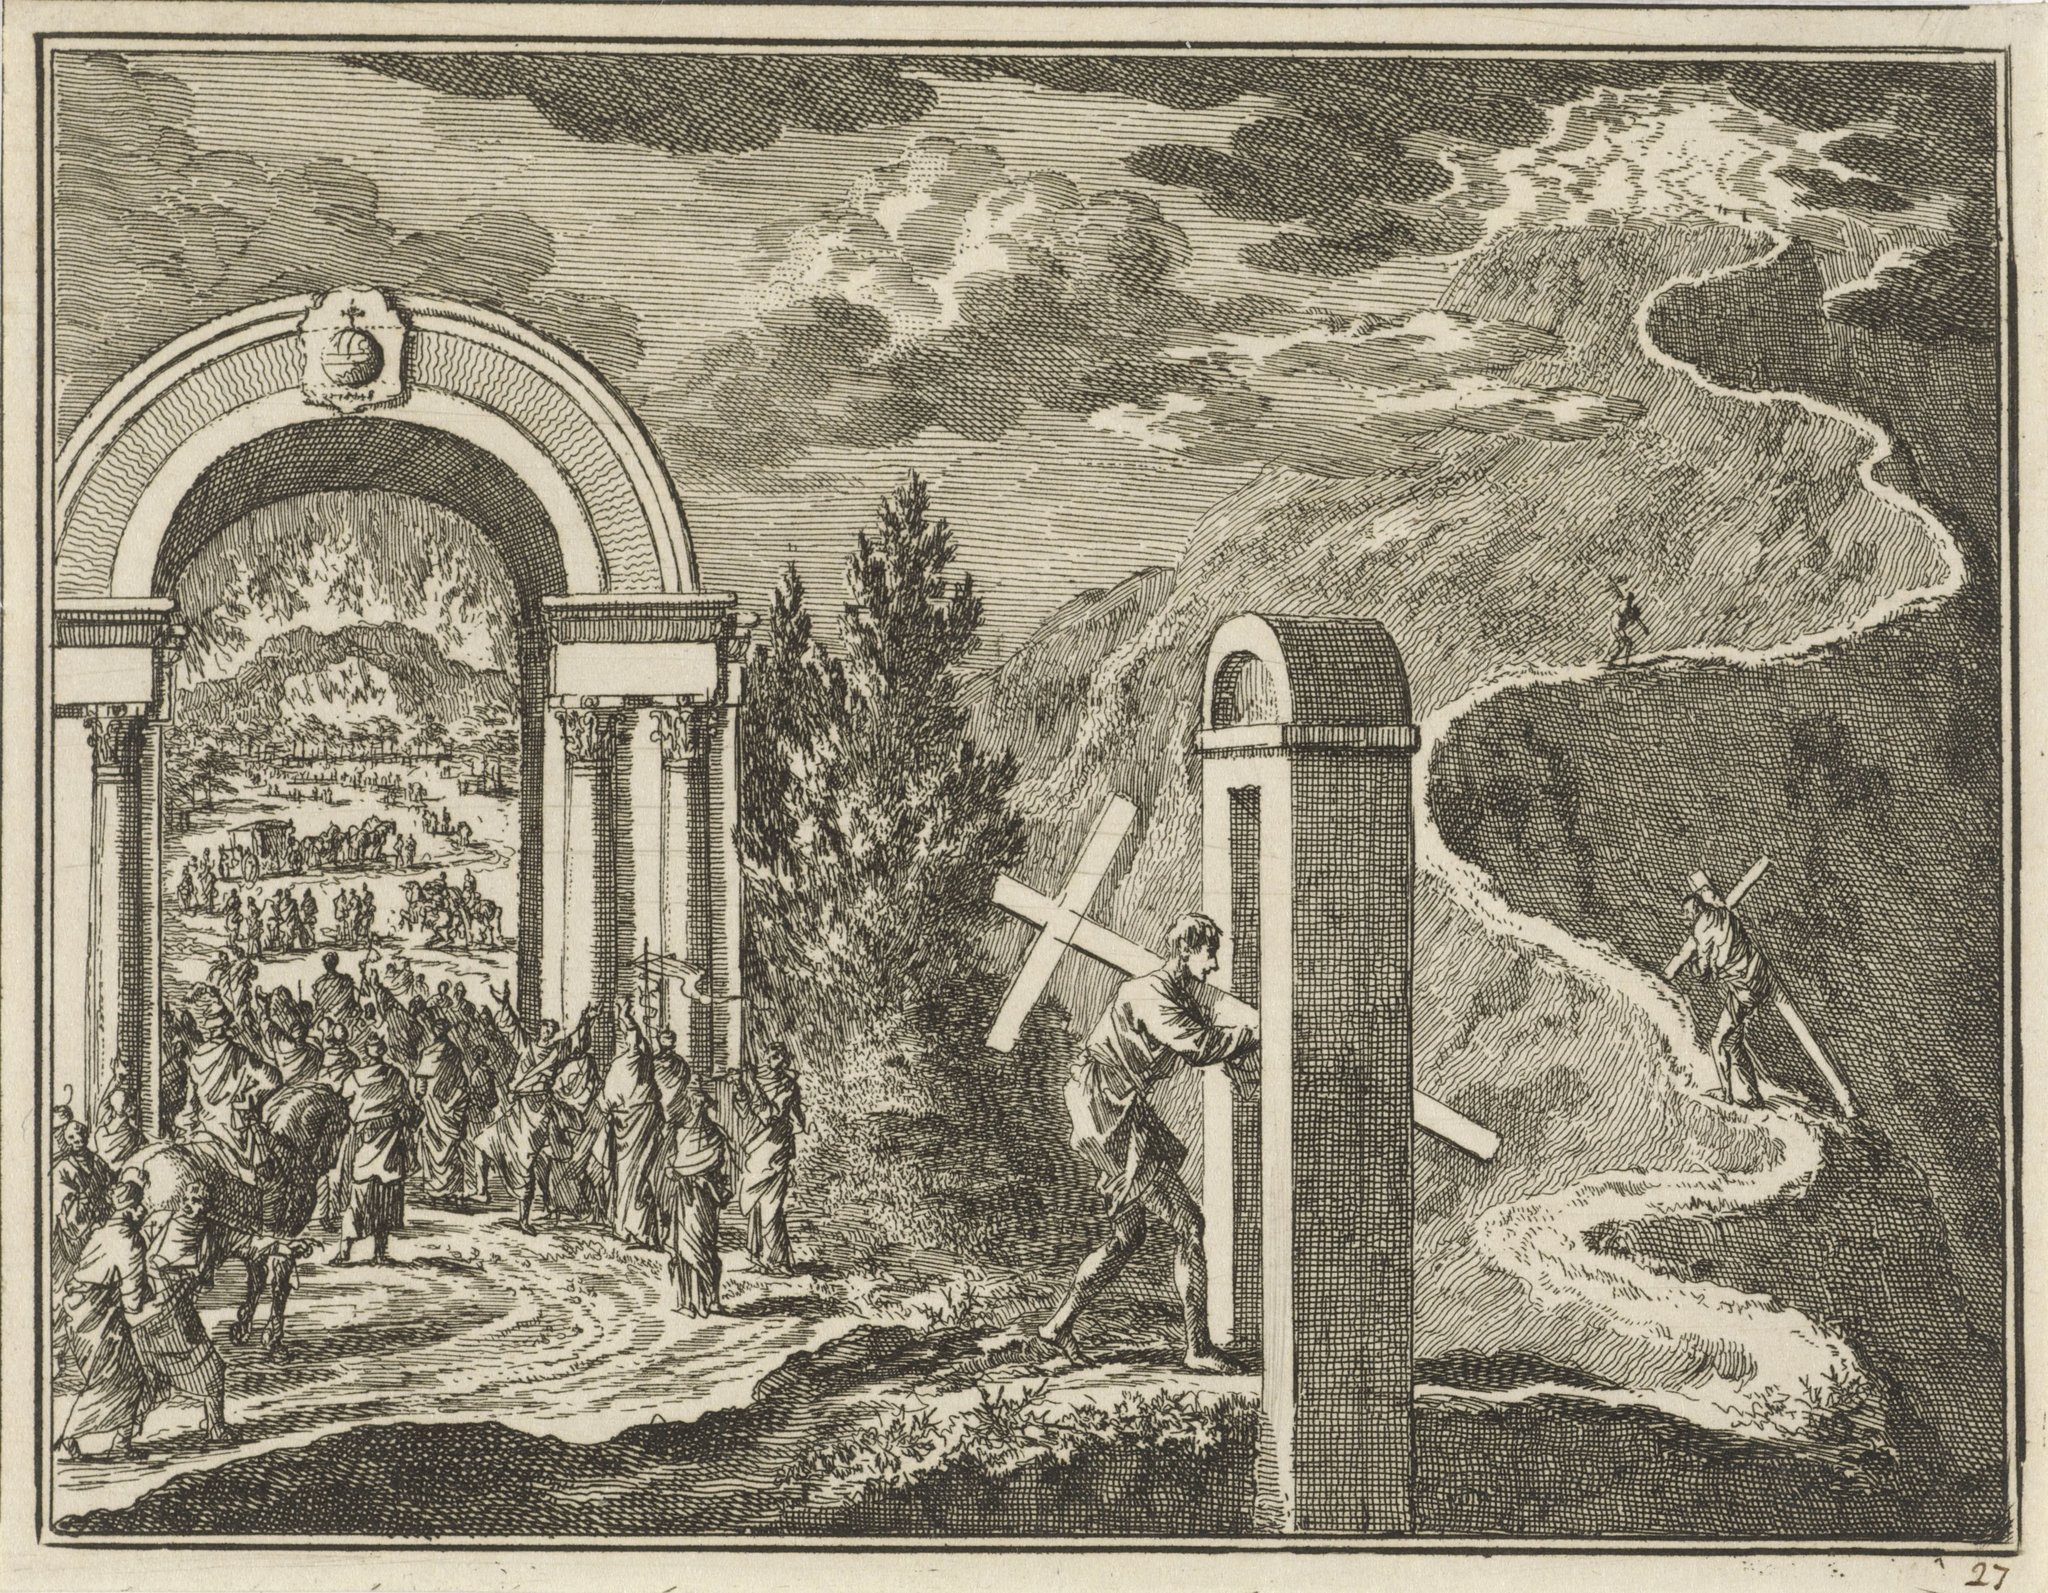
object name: print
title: Brede en de smalle weg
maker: jan luyken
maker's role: draughtsman, print maker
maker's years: 1649-1712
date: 1712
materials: paper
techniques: etching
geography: amsterdam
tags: the way to destruction is broad and the gate is wide; the way to life is narrow and the gate is straight ~ doctrine of christ on love, etc. (matthew 7:13-14; luke 13:24)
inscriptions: number: ‘27’, collector's mark: Lugt 2228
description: Proefdruk van illustratie uit: Luyken, Jan. De schriftuurlyke geschiedenissen en gelykenissen van het Oude en Nieuwe Verbond, 2 delen. Amsterdam: Wed. Pieter Arentsz II en Cornelis van der Sys, 1712, dl. II.